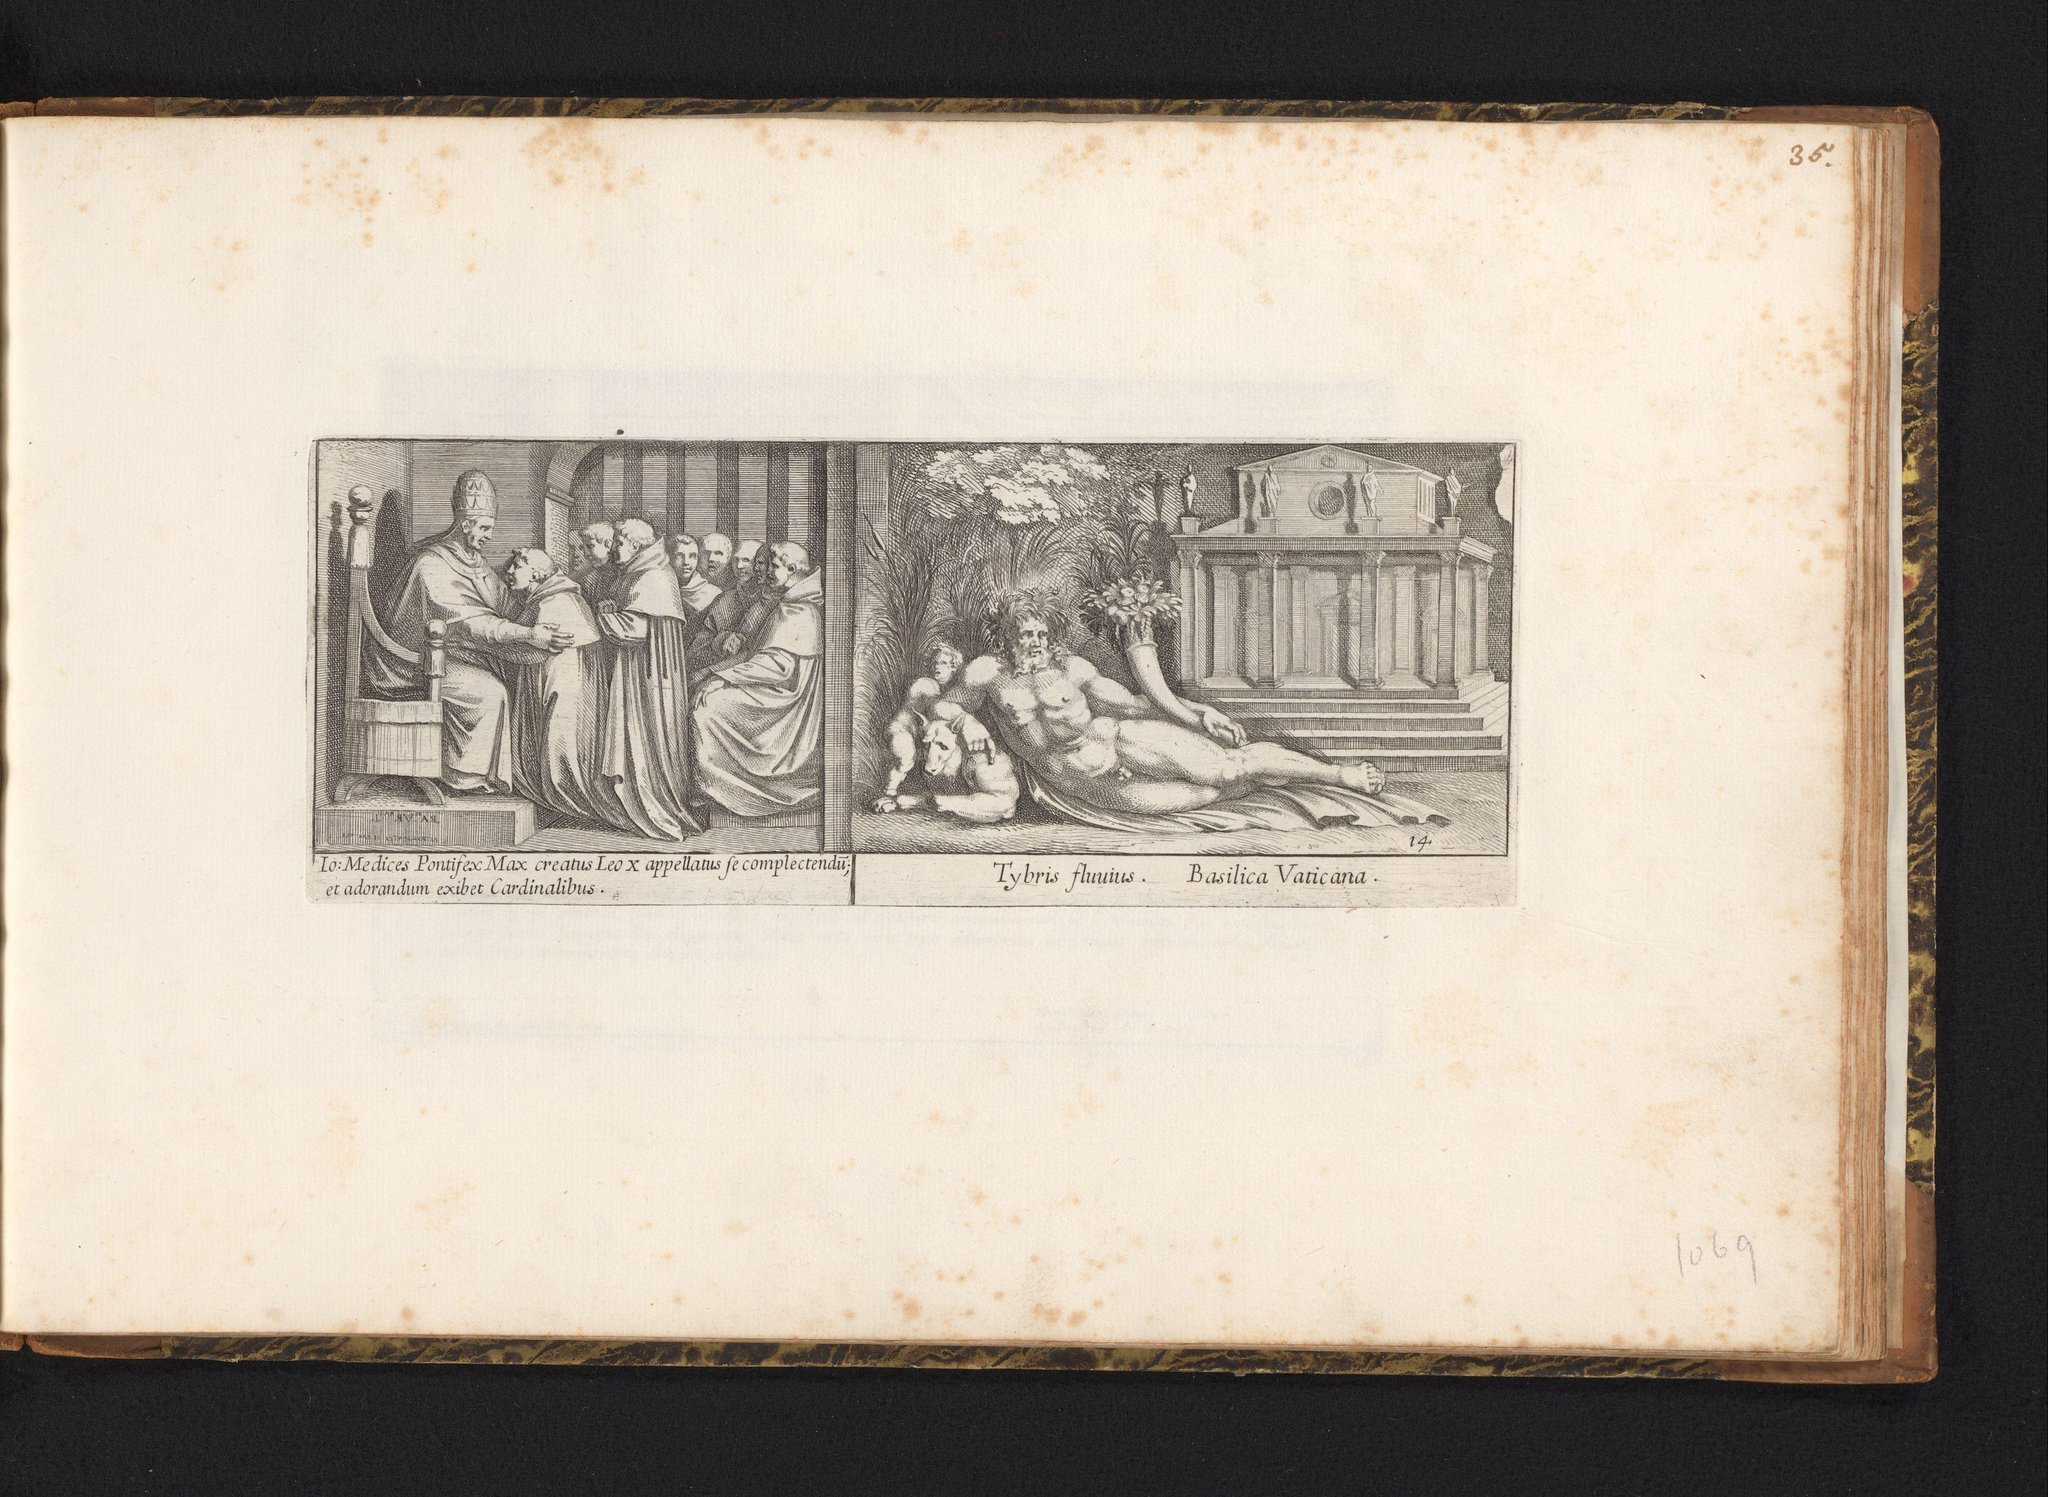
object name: print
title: Scènes uit het leven van paus Leo X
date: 1645-1700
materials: paper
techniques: engraving, etching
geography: rome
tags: rome, leo x, personification of river tiber; 'tevere' (ripa), cardinal, pope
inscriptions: number: ‘35’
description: Twee voorstellingen. Links: Giovanni de' Medici, verkozen tot paus Leo X, ontvangt het eerbetoon van de andere kardinalen. Rechts: een riviergod (de Tiber), een putto en een hond en op de achtergrond een basilica. Titel in ondermarge. Genummerd rechtsonder: 14. Prent maakt deel uit van een album.